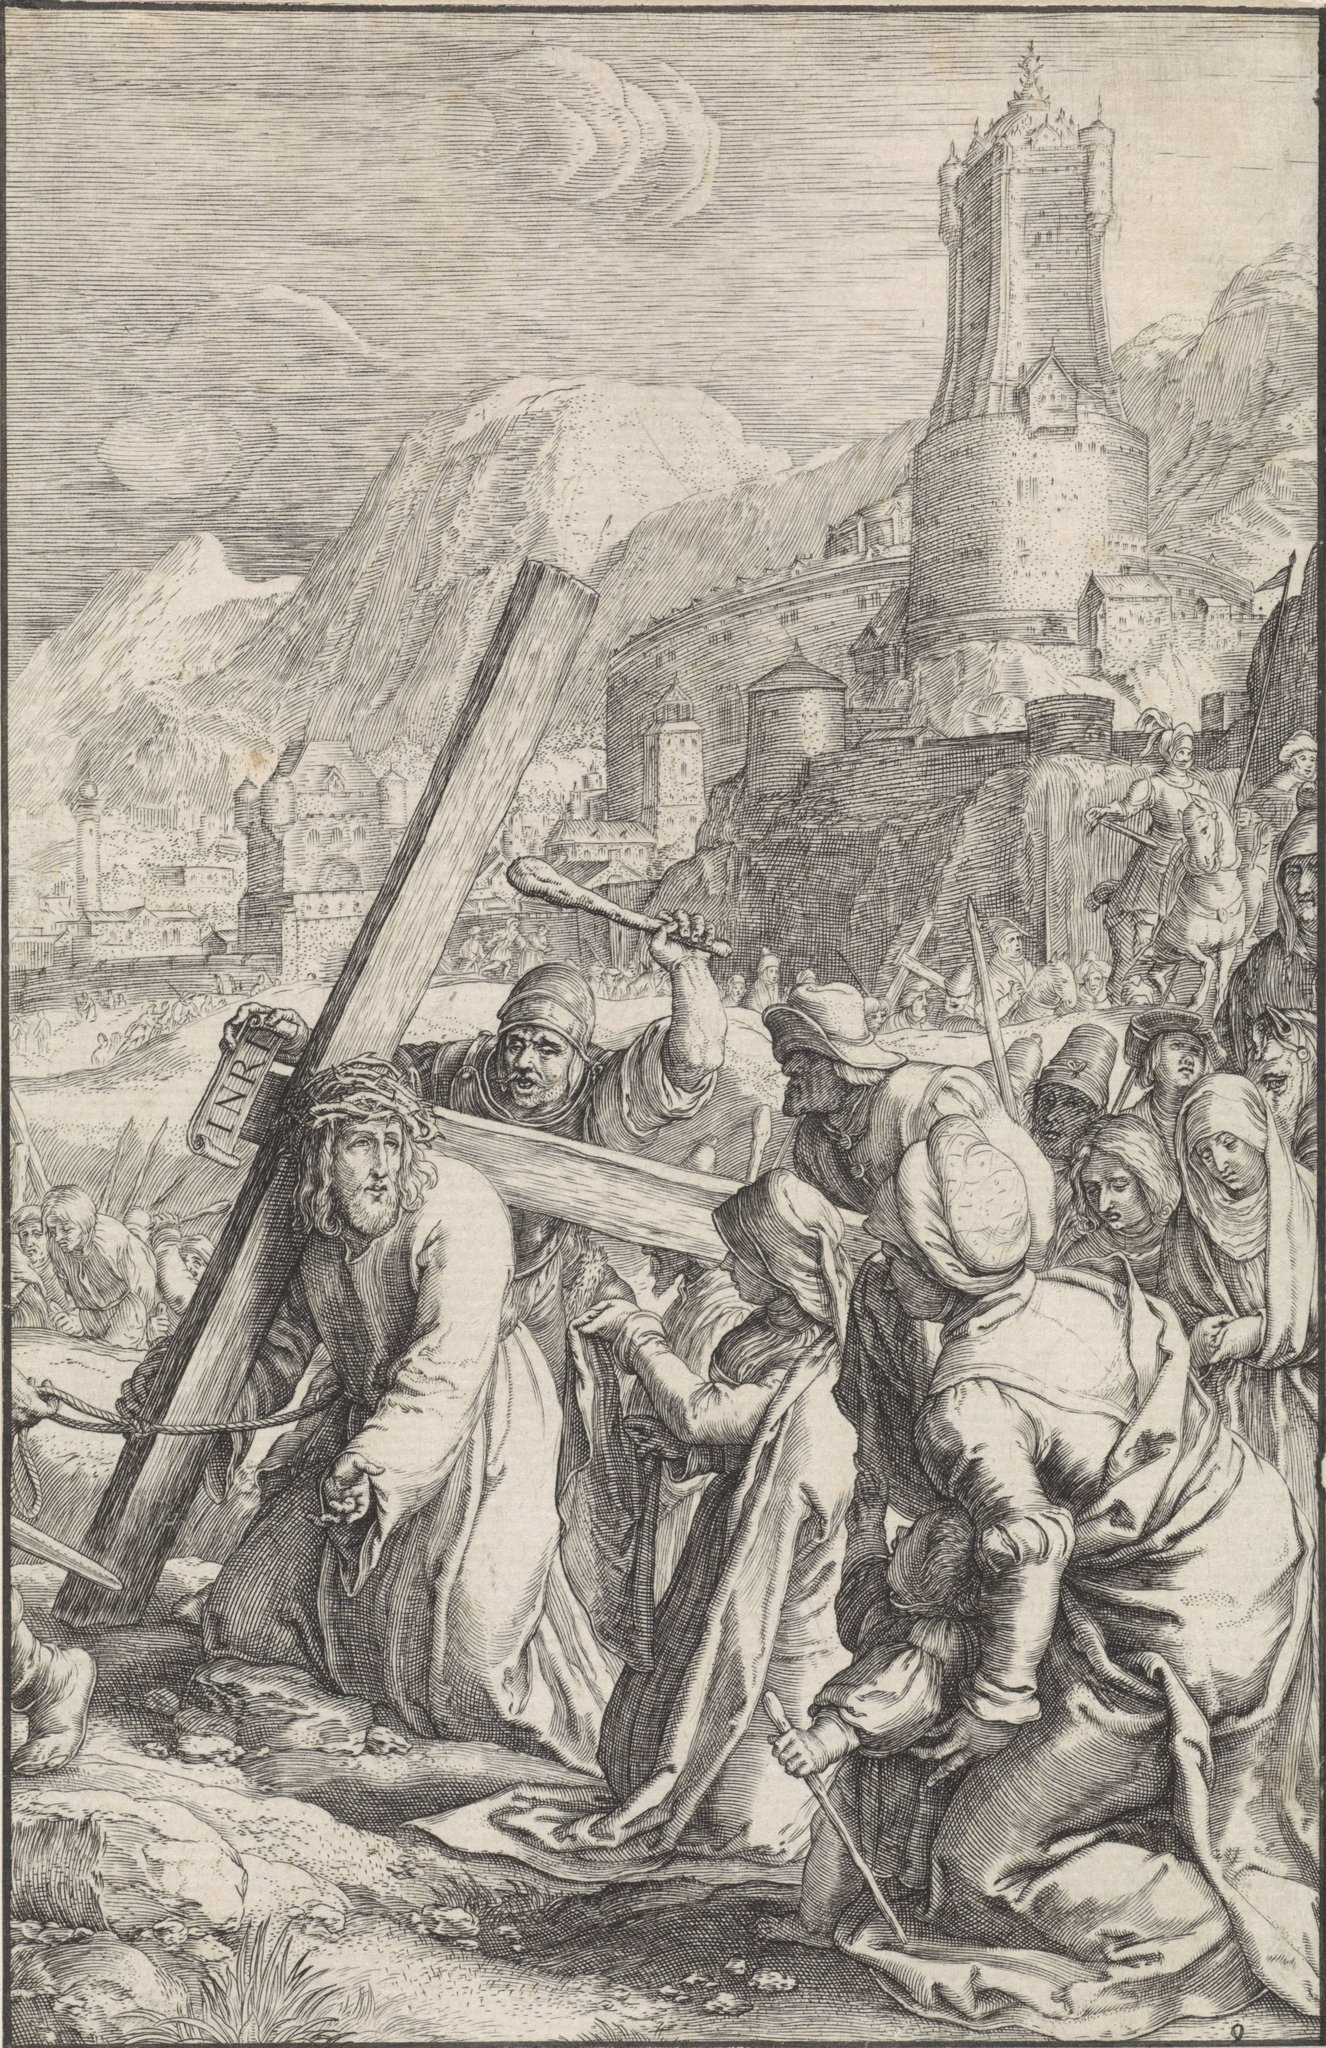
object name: print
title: Kruisdraging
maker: ludovicus siceram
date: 1623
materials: paper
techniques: engraving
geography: antwerp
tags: christ meets veronica, who has a cloth to wipe christ's face, carrying of the cross: christ bearing the cross, alone or with the help of others (e.g. simon the cyrenian)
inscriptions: collector's mark: Lugt 2228a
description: Christus draagt het kruis naar Golgota. Veronica knielt naast hem en biedt hem een doek aan. Achter hen de stoet met onder andere Maria en Johannes. Op de achtergrond Jeruzalem.